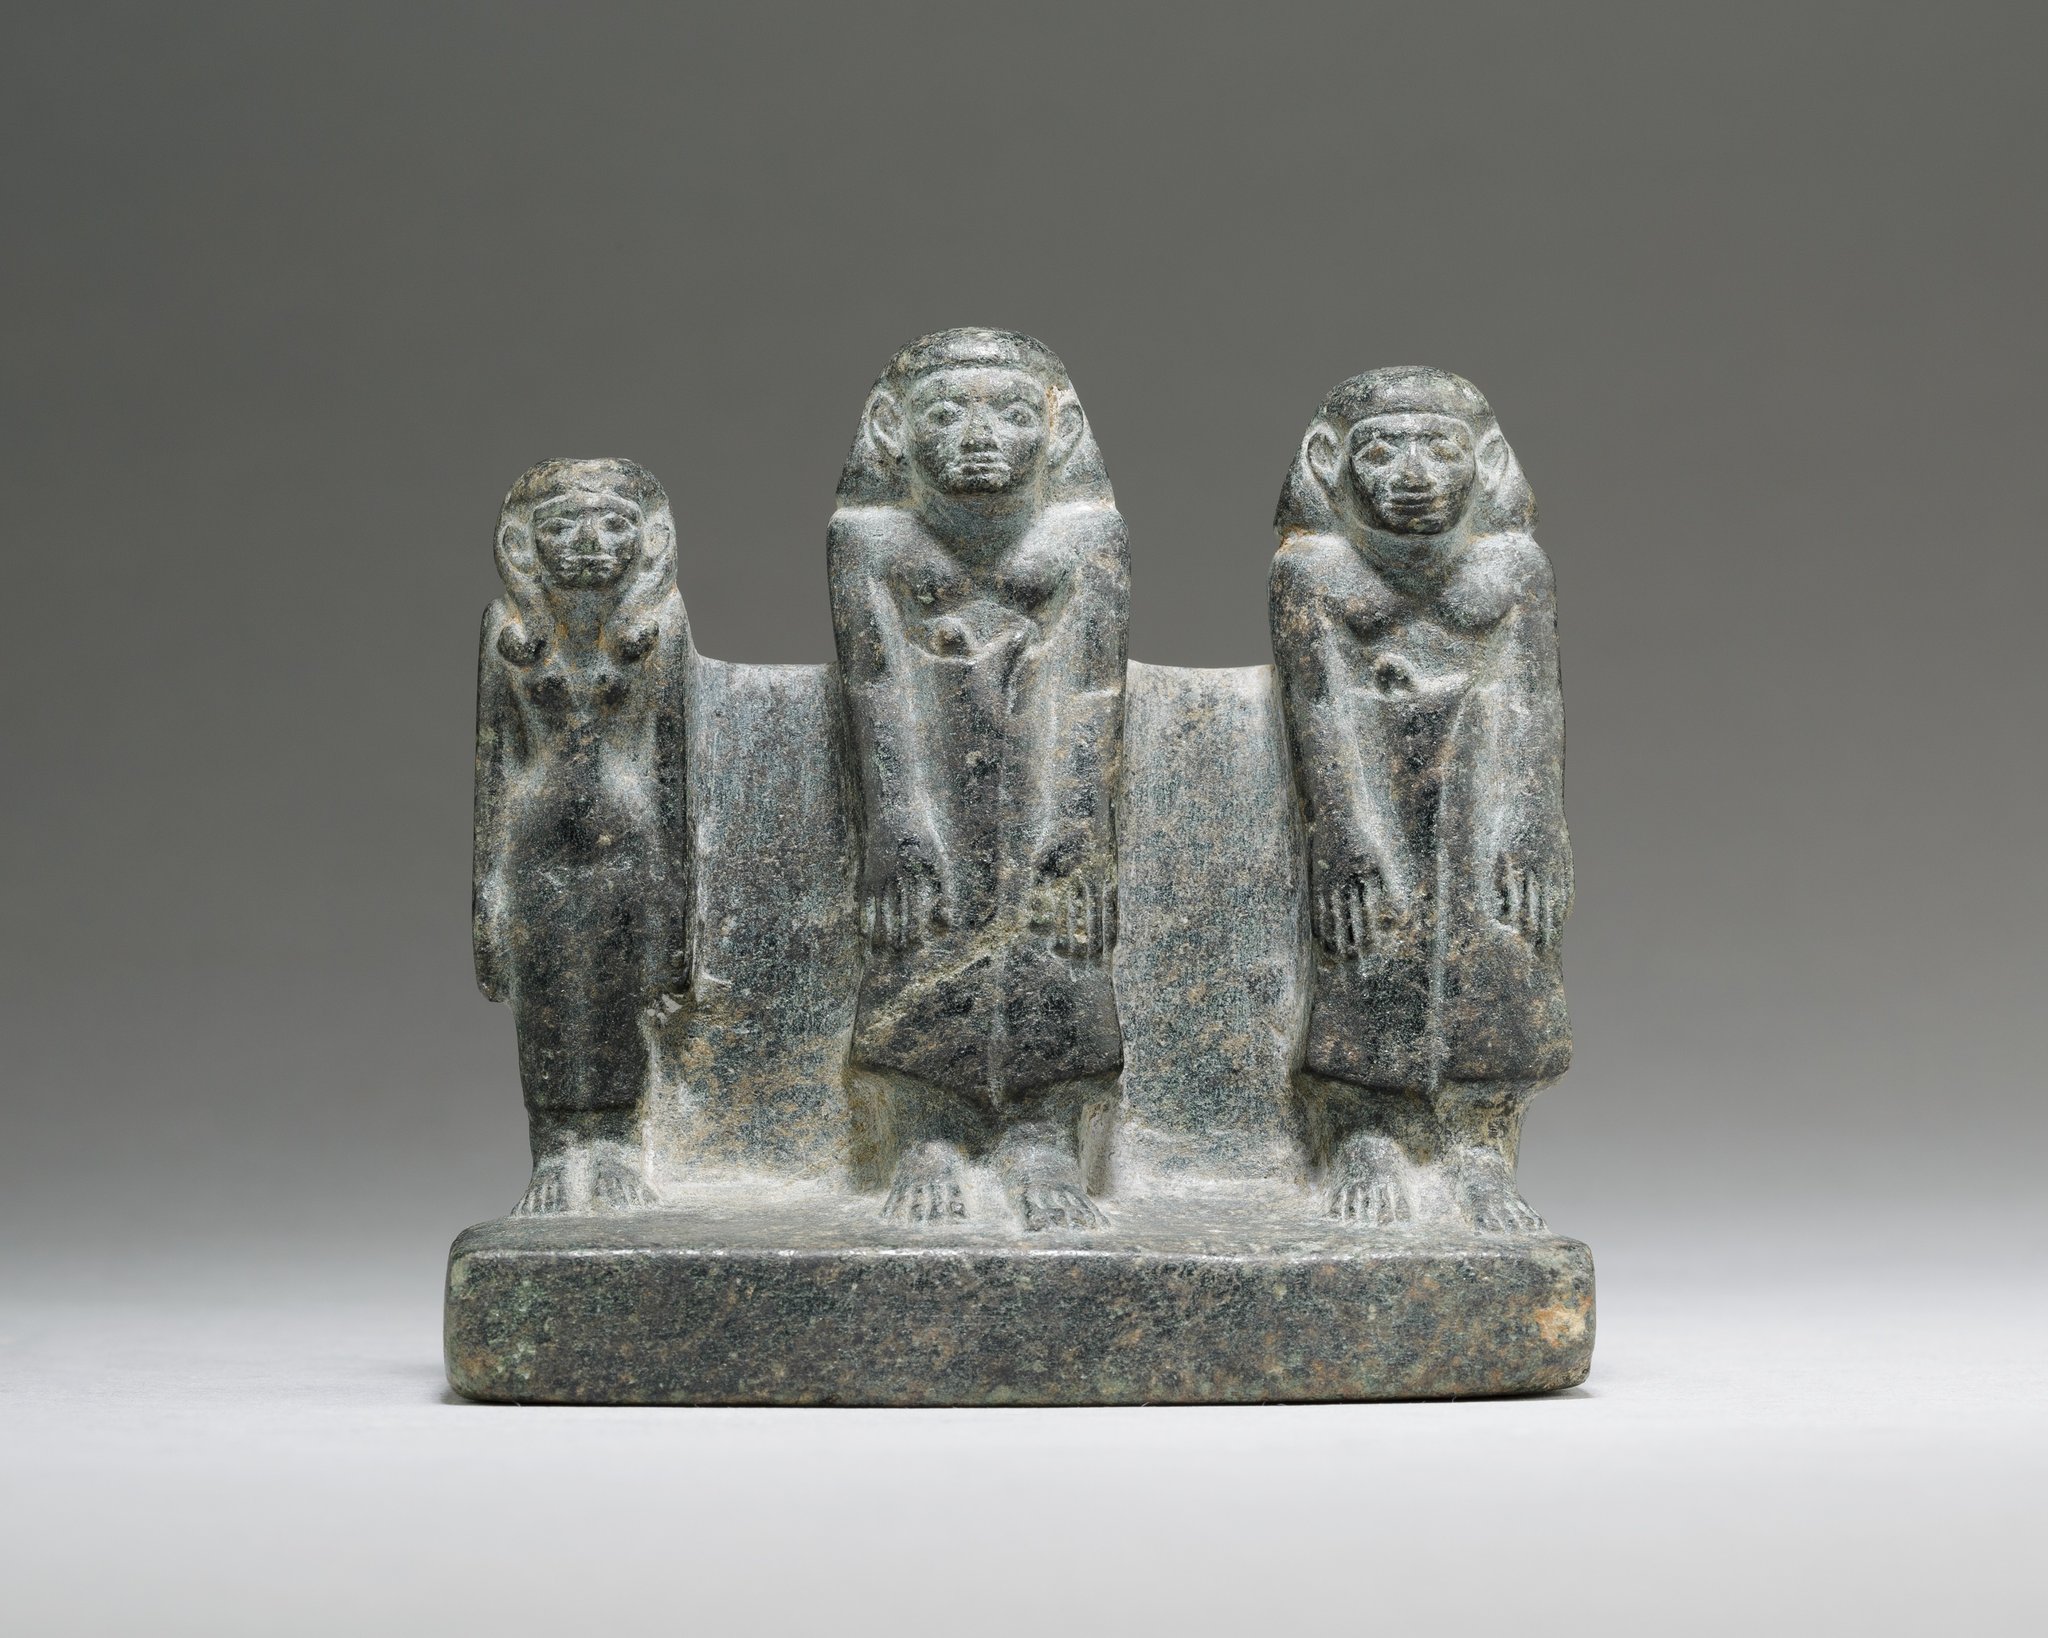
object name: statuette group, two men, woman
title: Group statuette of two men and a woman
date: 1981-1550 BCE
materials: stone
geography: egypt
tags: men,women